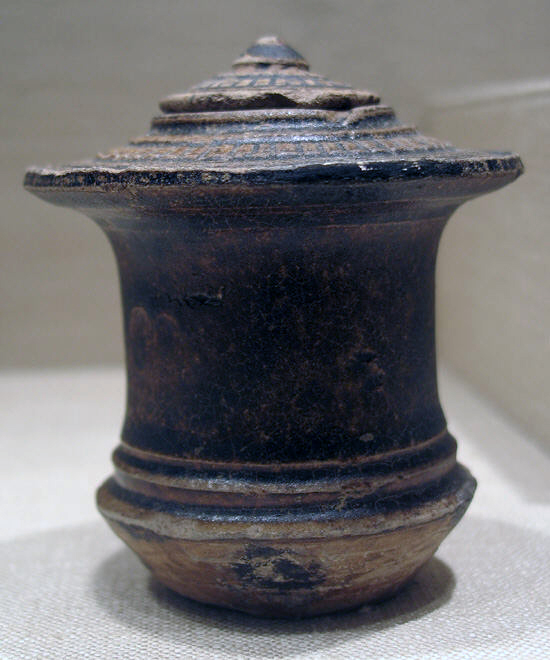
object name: jar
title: Covered Cylinderical Jar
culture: thailand, buriram province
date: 1001-1100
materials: stoneware